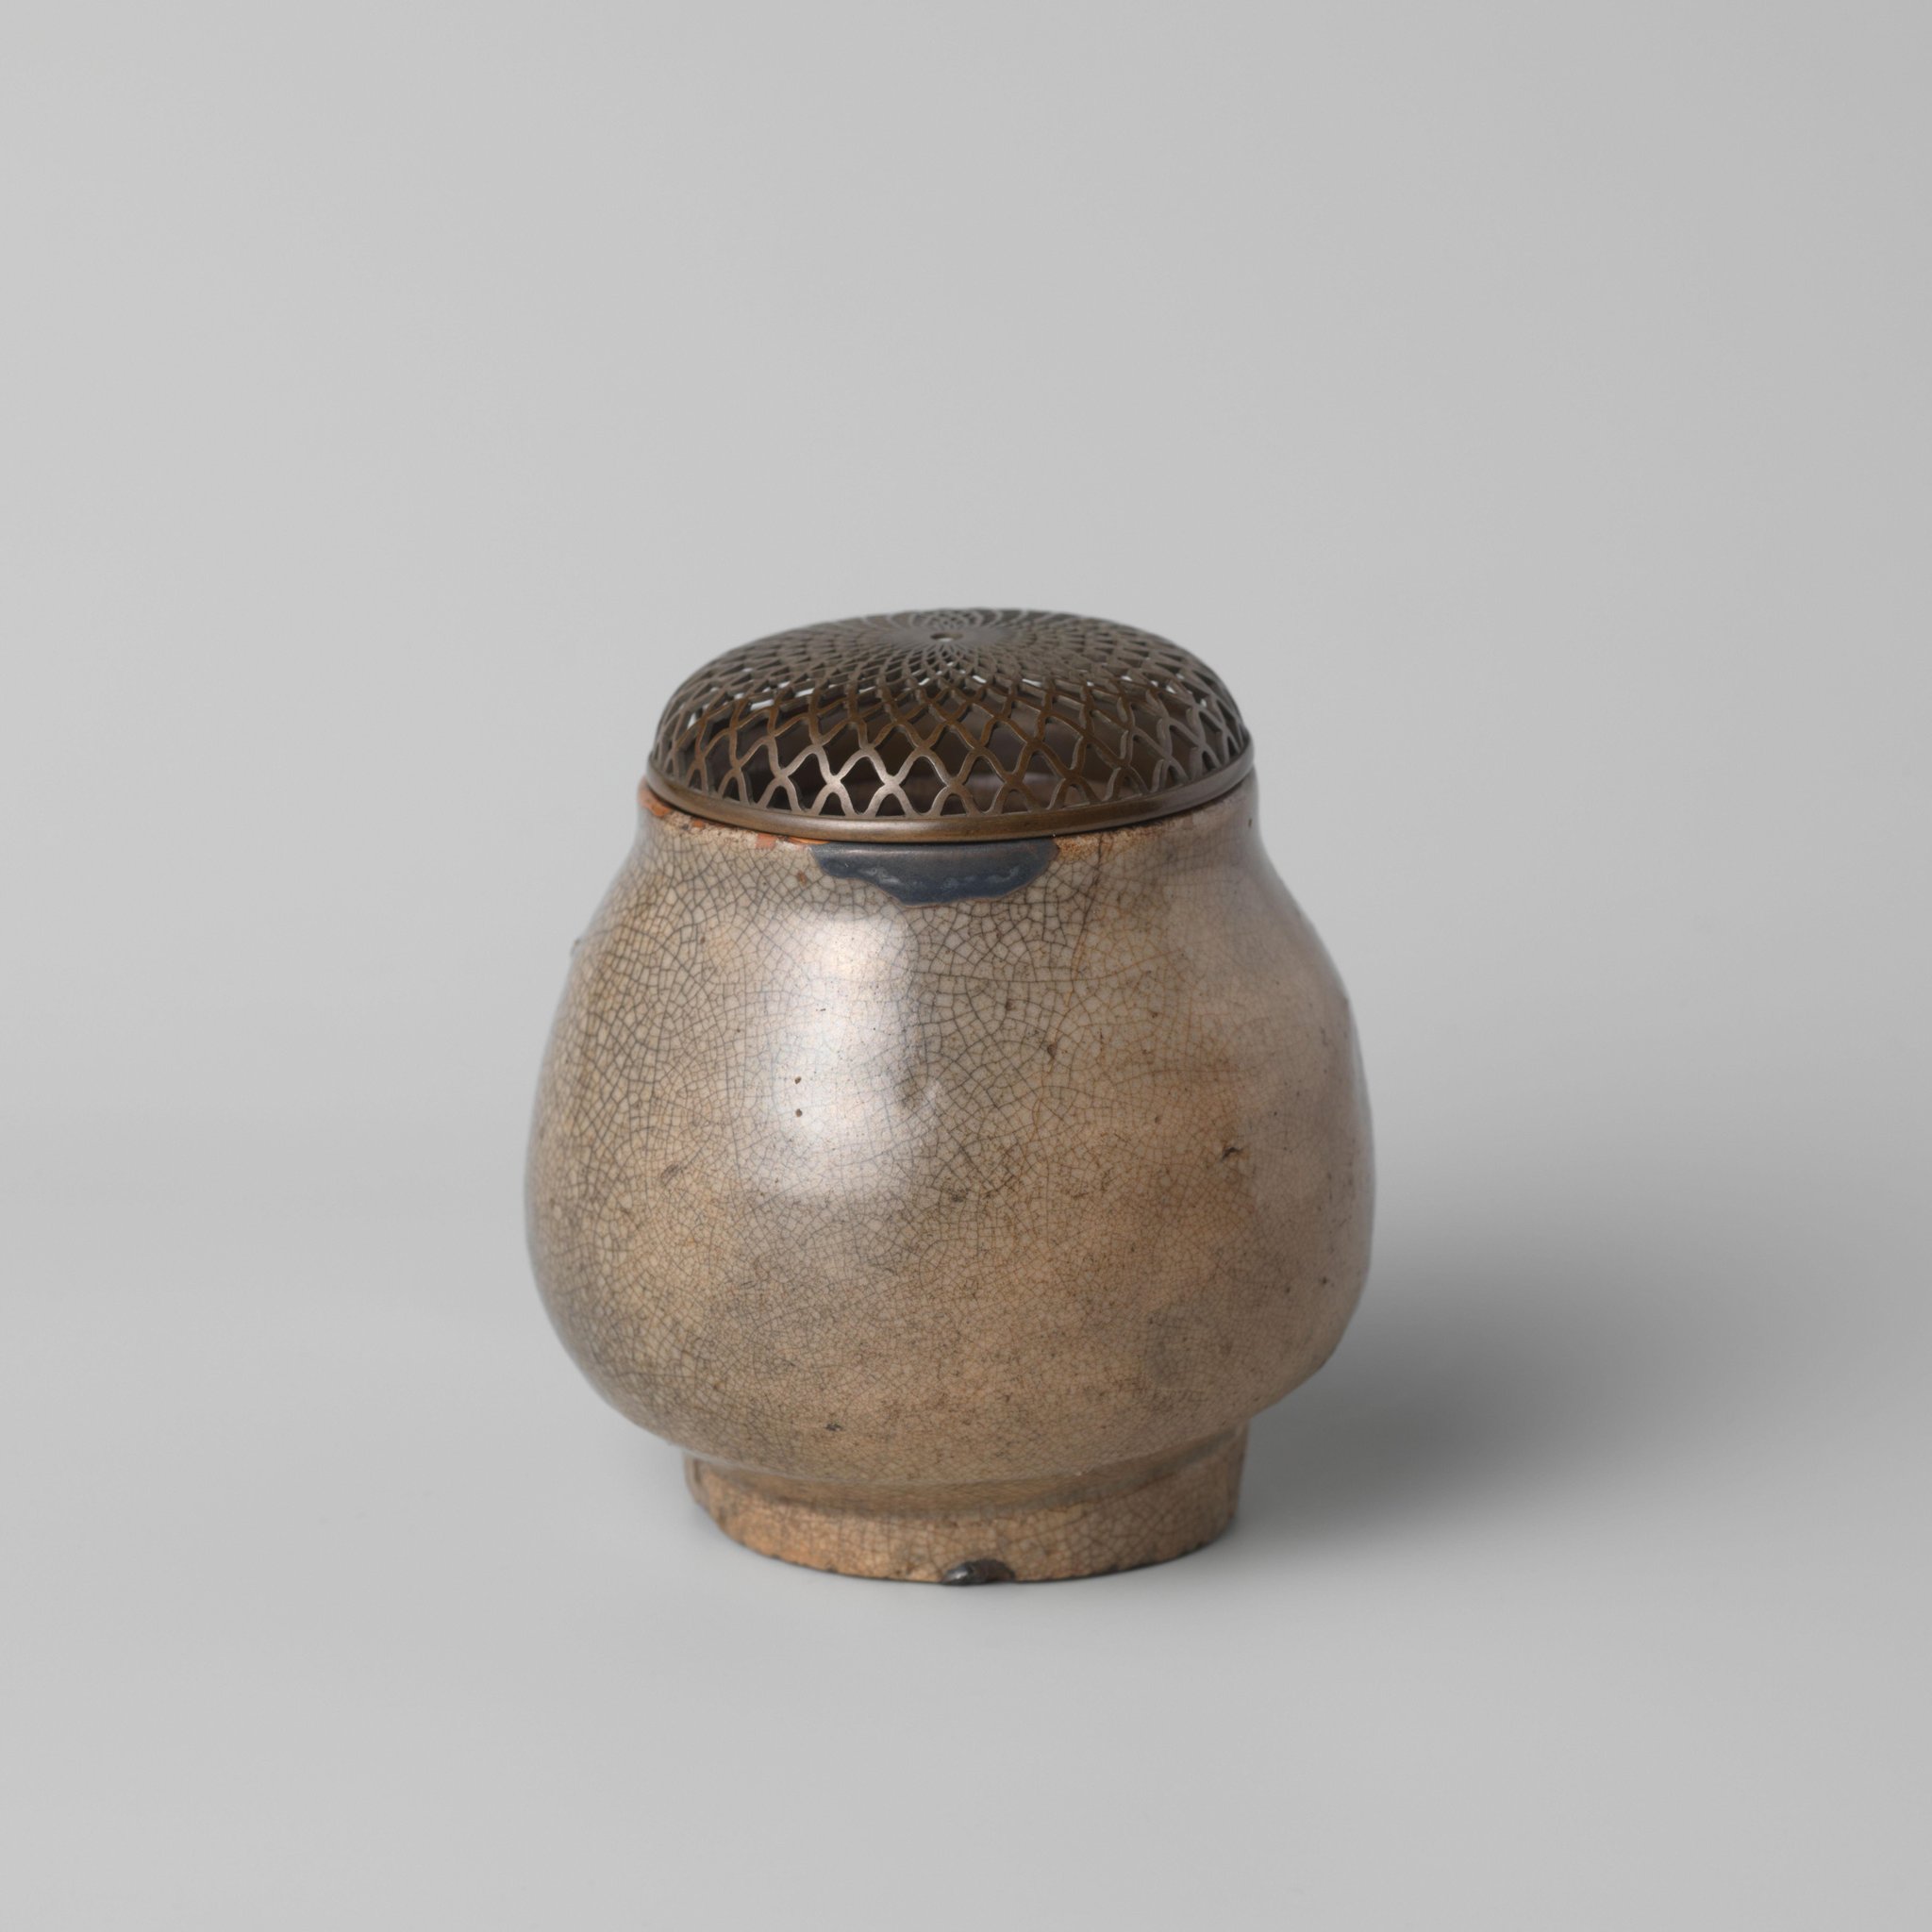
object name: lid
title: Incense burner with a copper cover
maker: Anonymous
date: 1600-1699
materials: copper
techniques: firing, turning, vitrification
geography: korea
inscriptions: label: ‘Korea 33/ Vente Bing[?] 226’, label: ‘W137’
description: Opengewerkte, koperen deksel van wierookbrander van steengoed. Vier gegraveerde tekens in de rand. Oud label op de onderzijde met 'W137' en 'Korea 33/ Vente Bing[?] 226'.